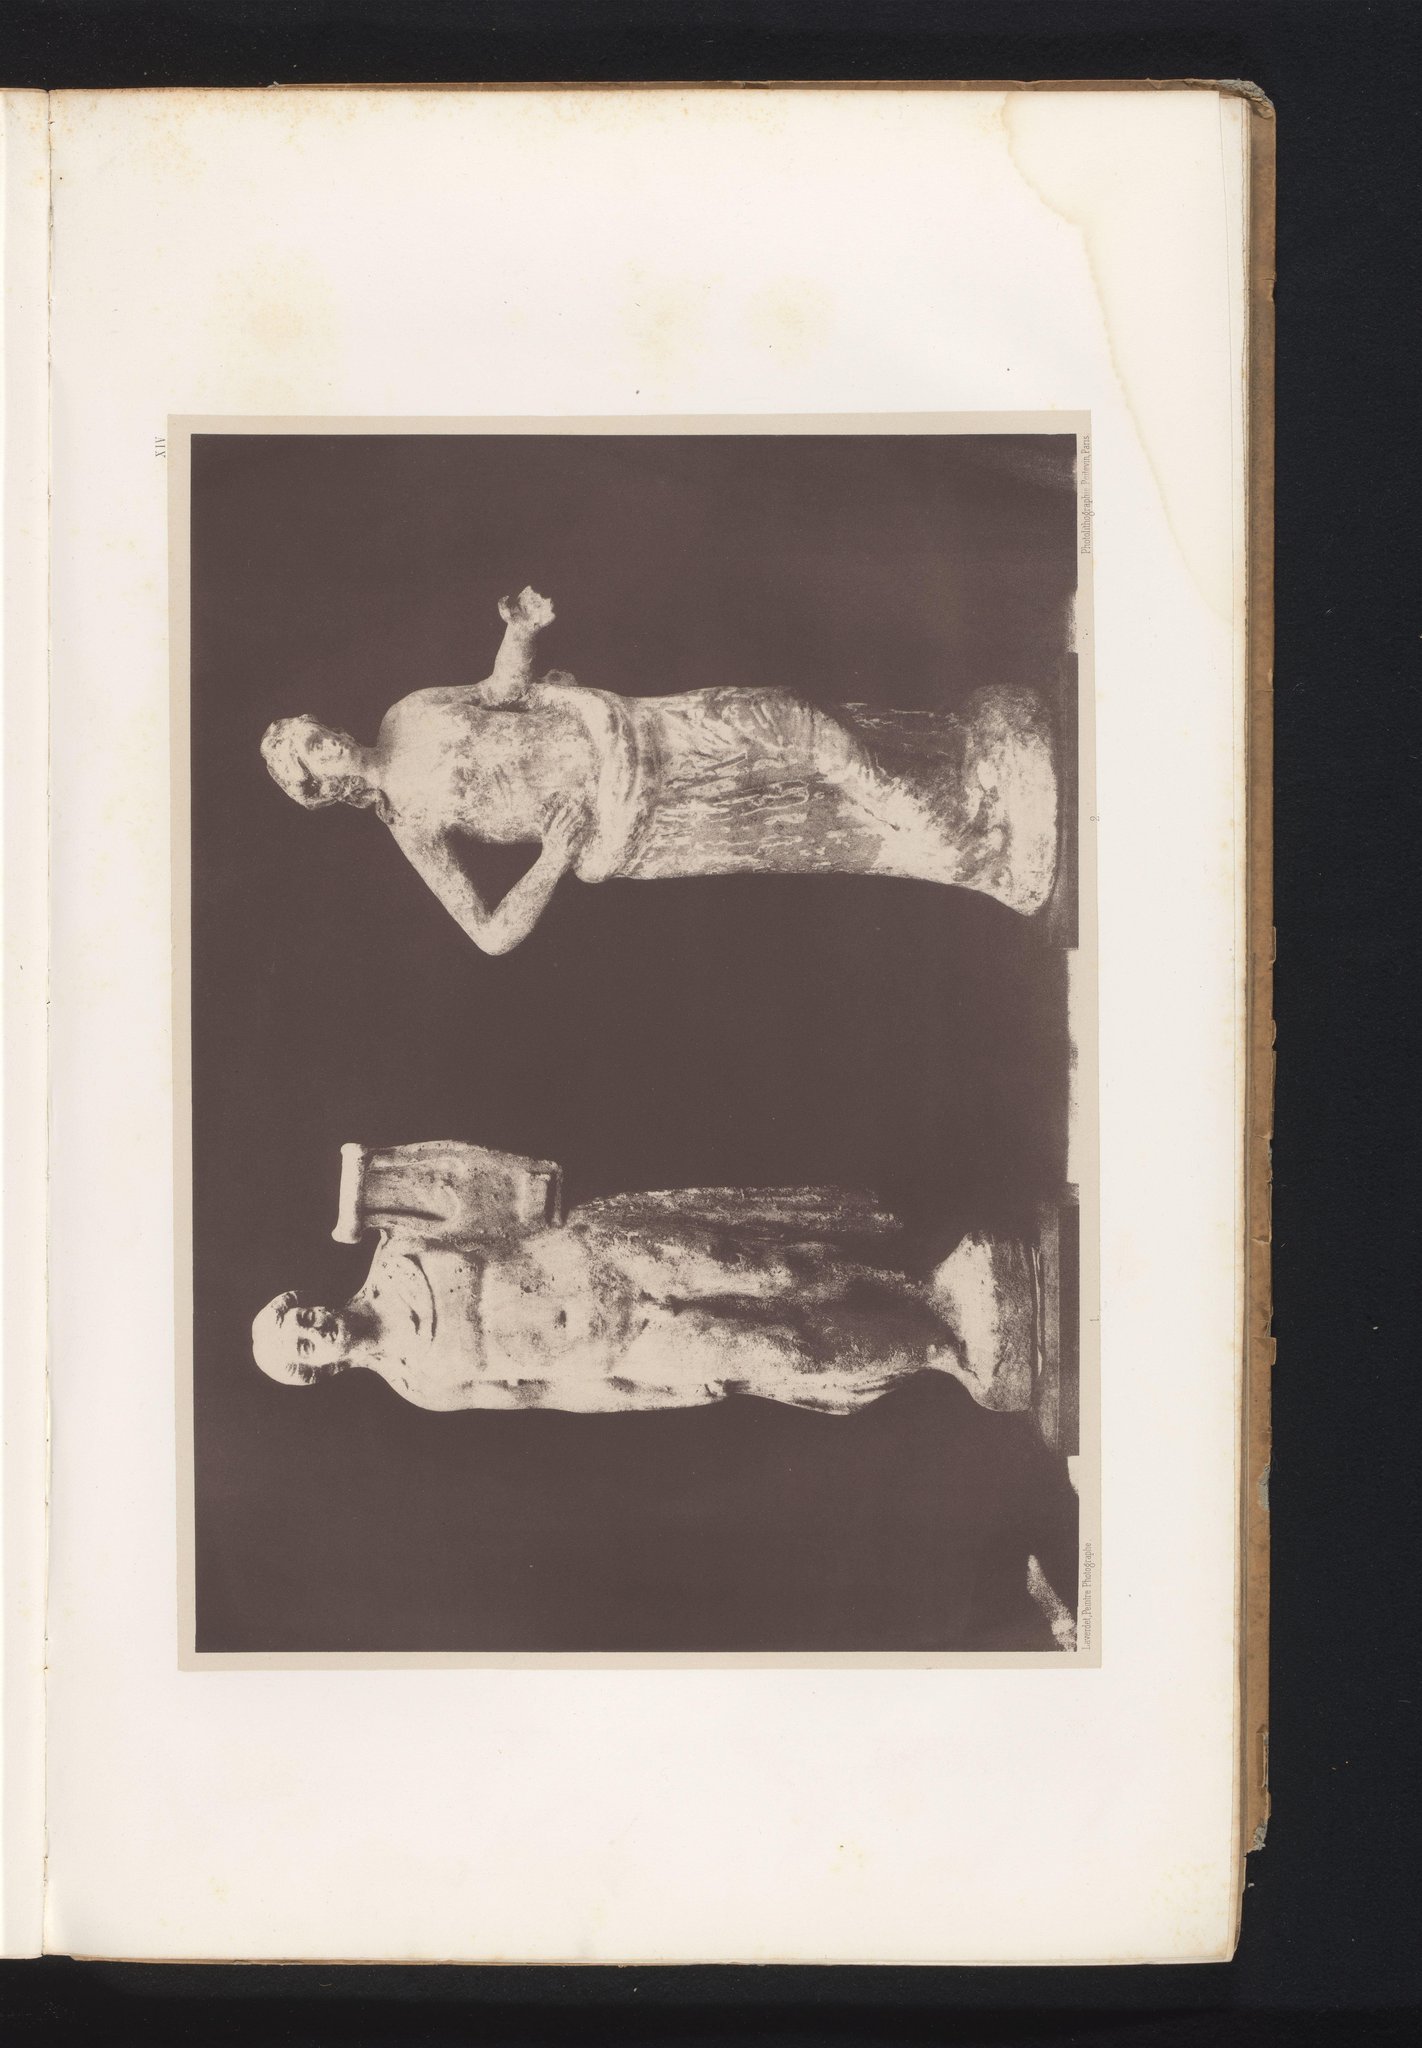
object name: page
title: Twee terracotta sculpturen van Apollo en een halfnaakte vrouw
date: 1852-1857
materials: paper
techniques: photolithography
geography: paris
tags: (story of) apollo (phoebus), piece of sculpture, reproduction of a piece of sculpture (+ clay, sand, etc. ~ arts), woman (showing herself) undressed, quasi-nude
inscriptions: number: ‘1. 2.’, number: ‘XIV.’